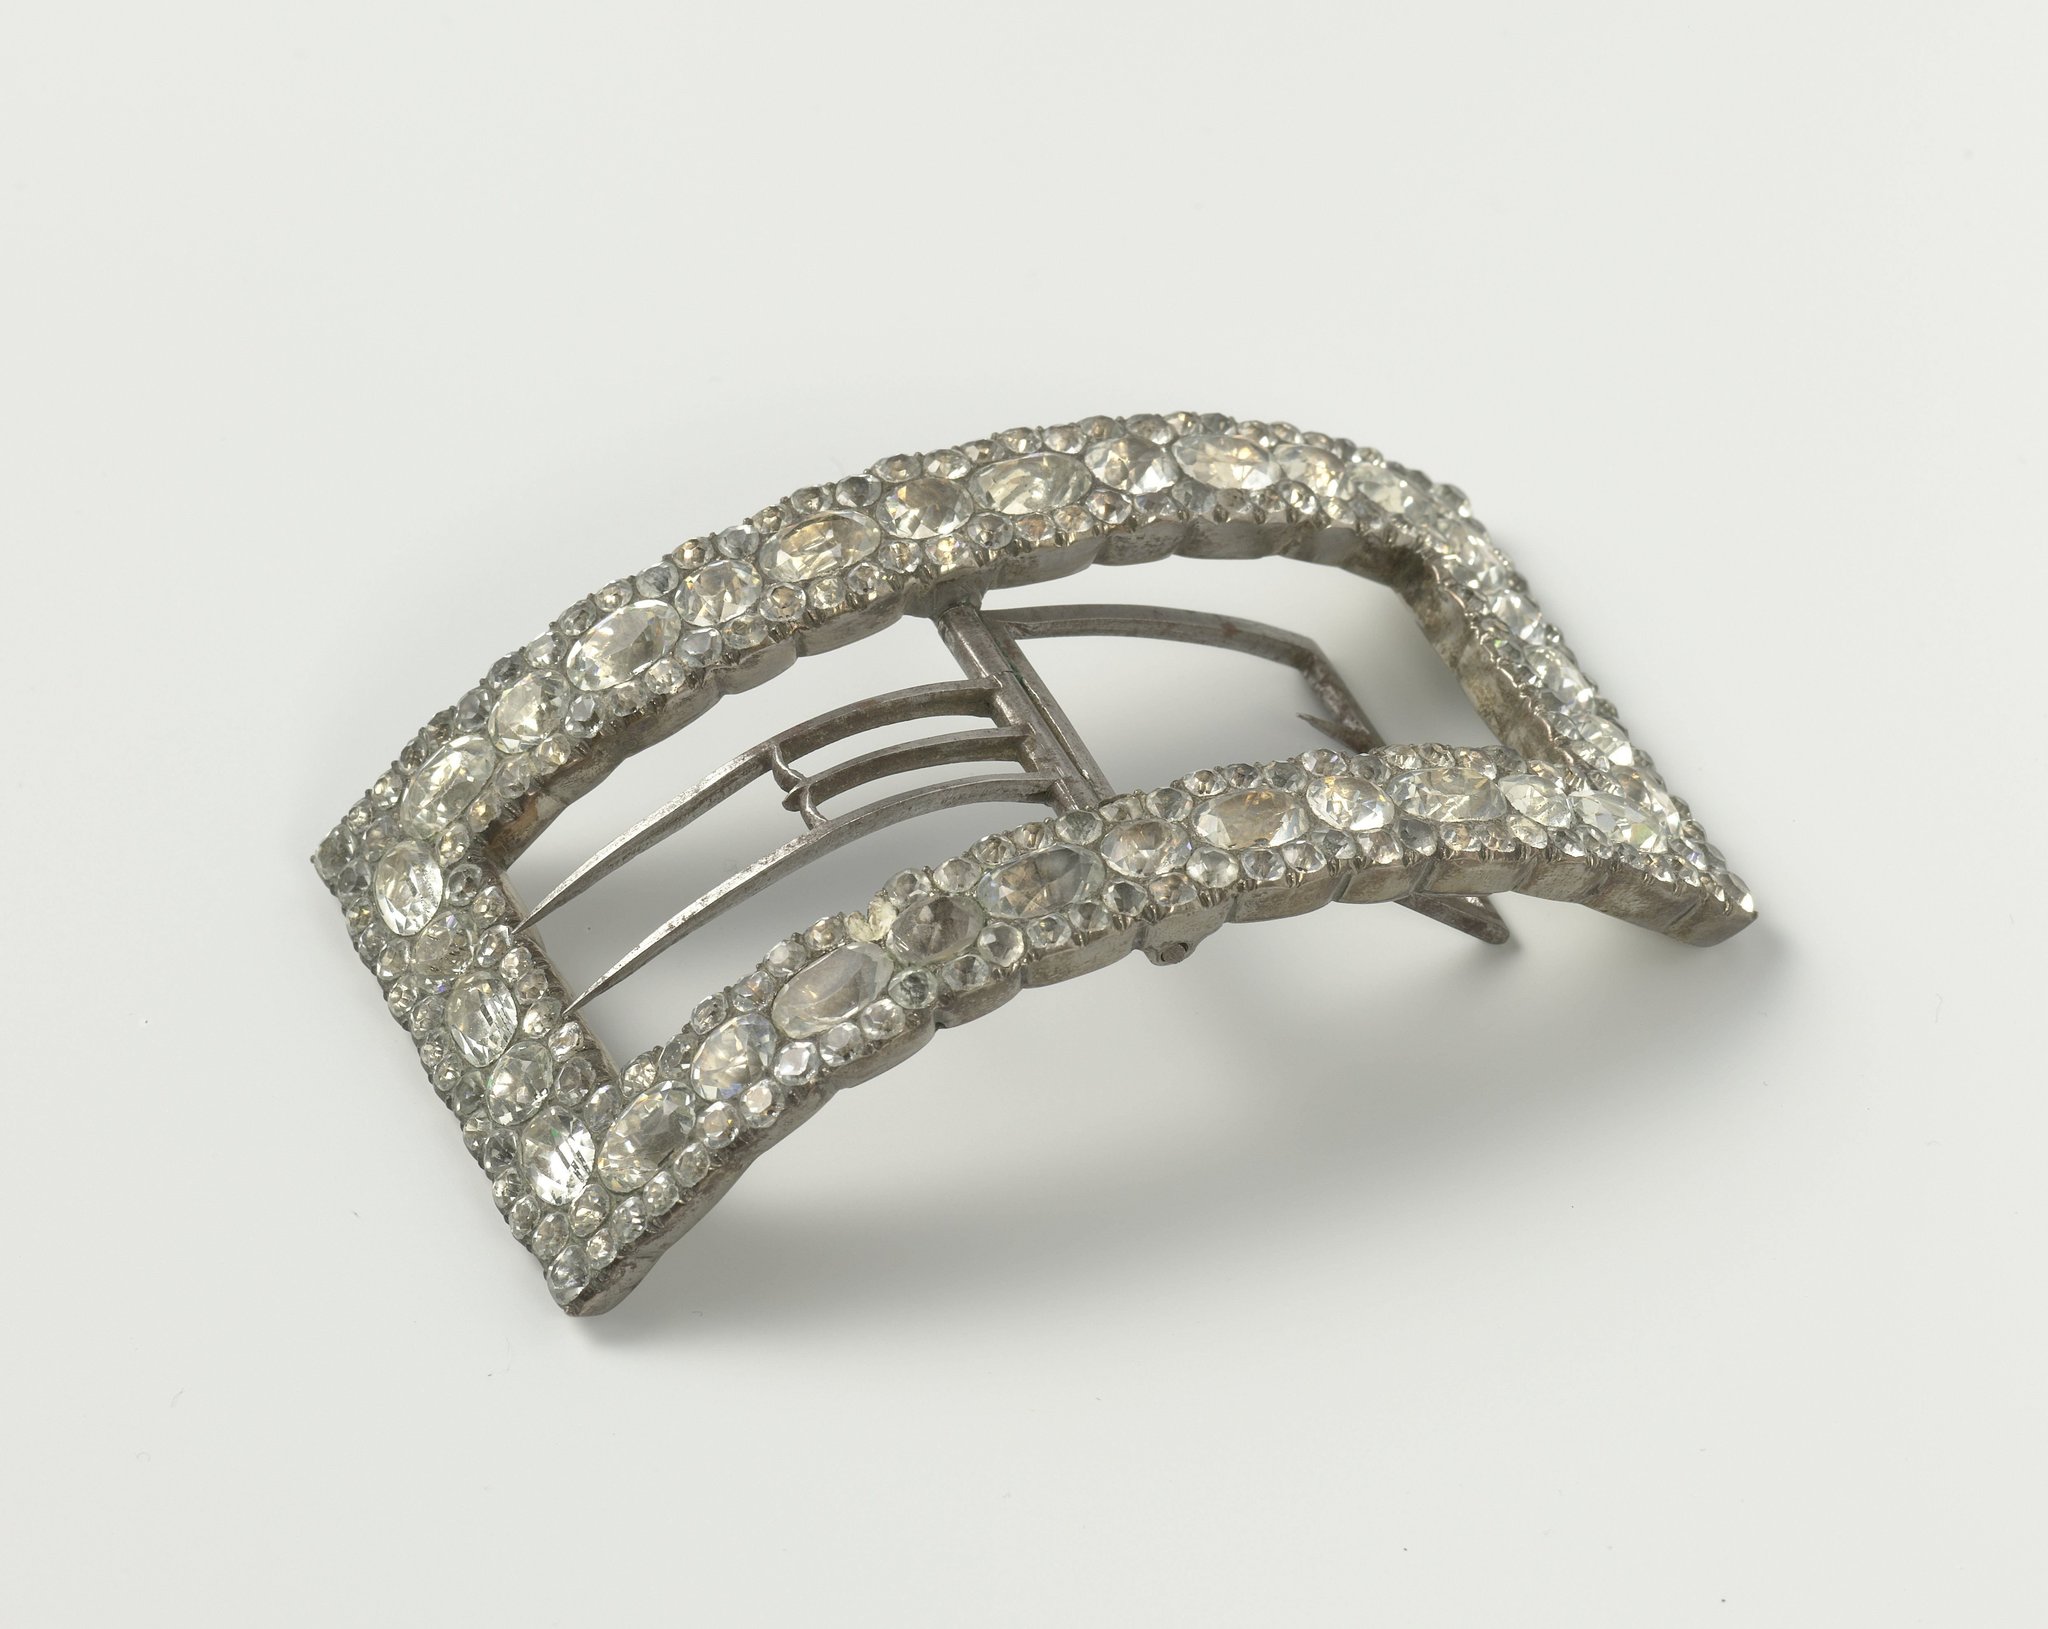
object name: shoe buckle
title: Gesp, rechthoekig en gewelfd, bestaande uit middenrand van afwisselend grote ovale en ronde strasstrenen, omlijst door kleinere strasstenen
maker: Anonymous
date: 1775-1800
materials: iron, paste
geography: france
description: Schoengesp voor een herenschoen, of een ceintuurgesp van strasz in wit metaal. Een gewelfde rechthoek bestaat uit een middenrand van afwisselend grote ovale en ronde straszdiamanten, omlijst door kleinere straszdiamanten. Dichte vatiing van verzilverd koper (?). Twee scherpe tanden van ijzer voor bevestiging.